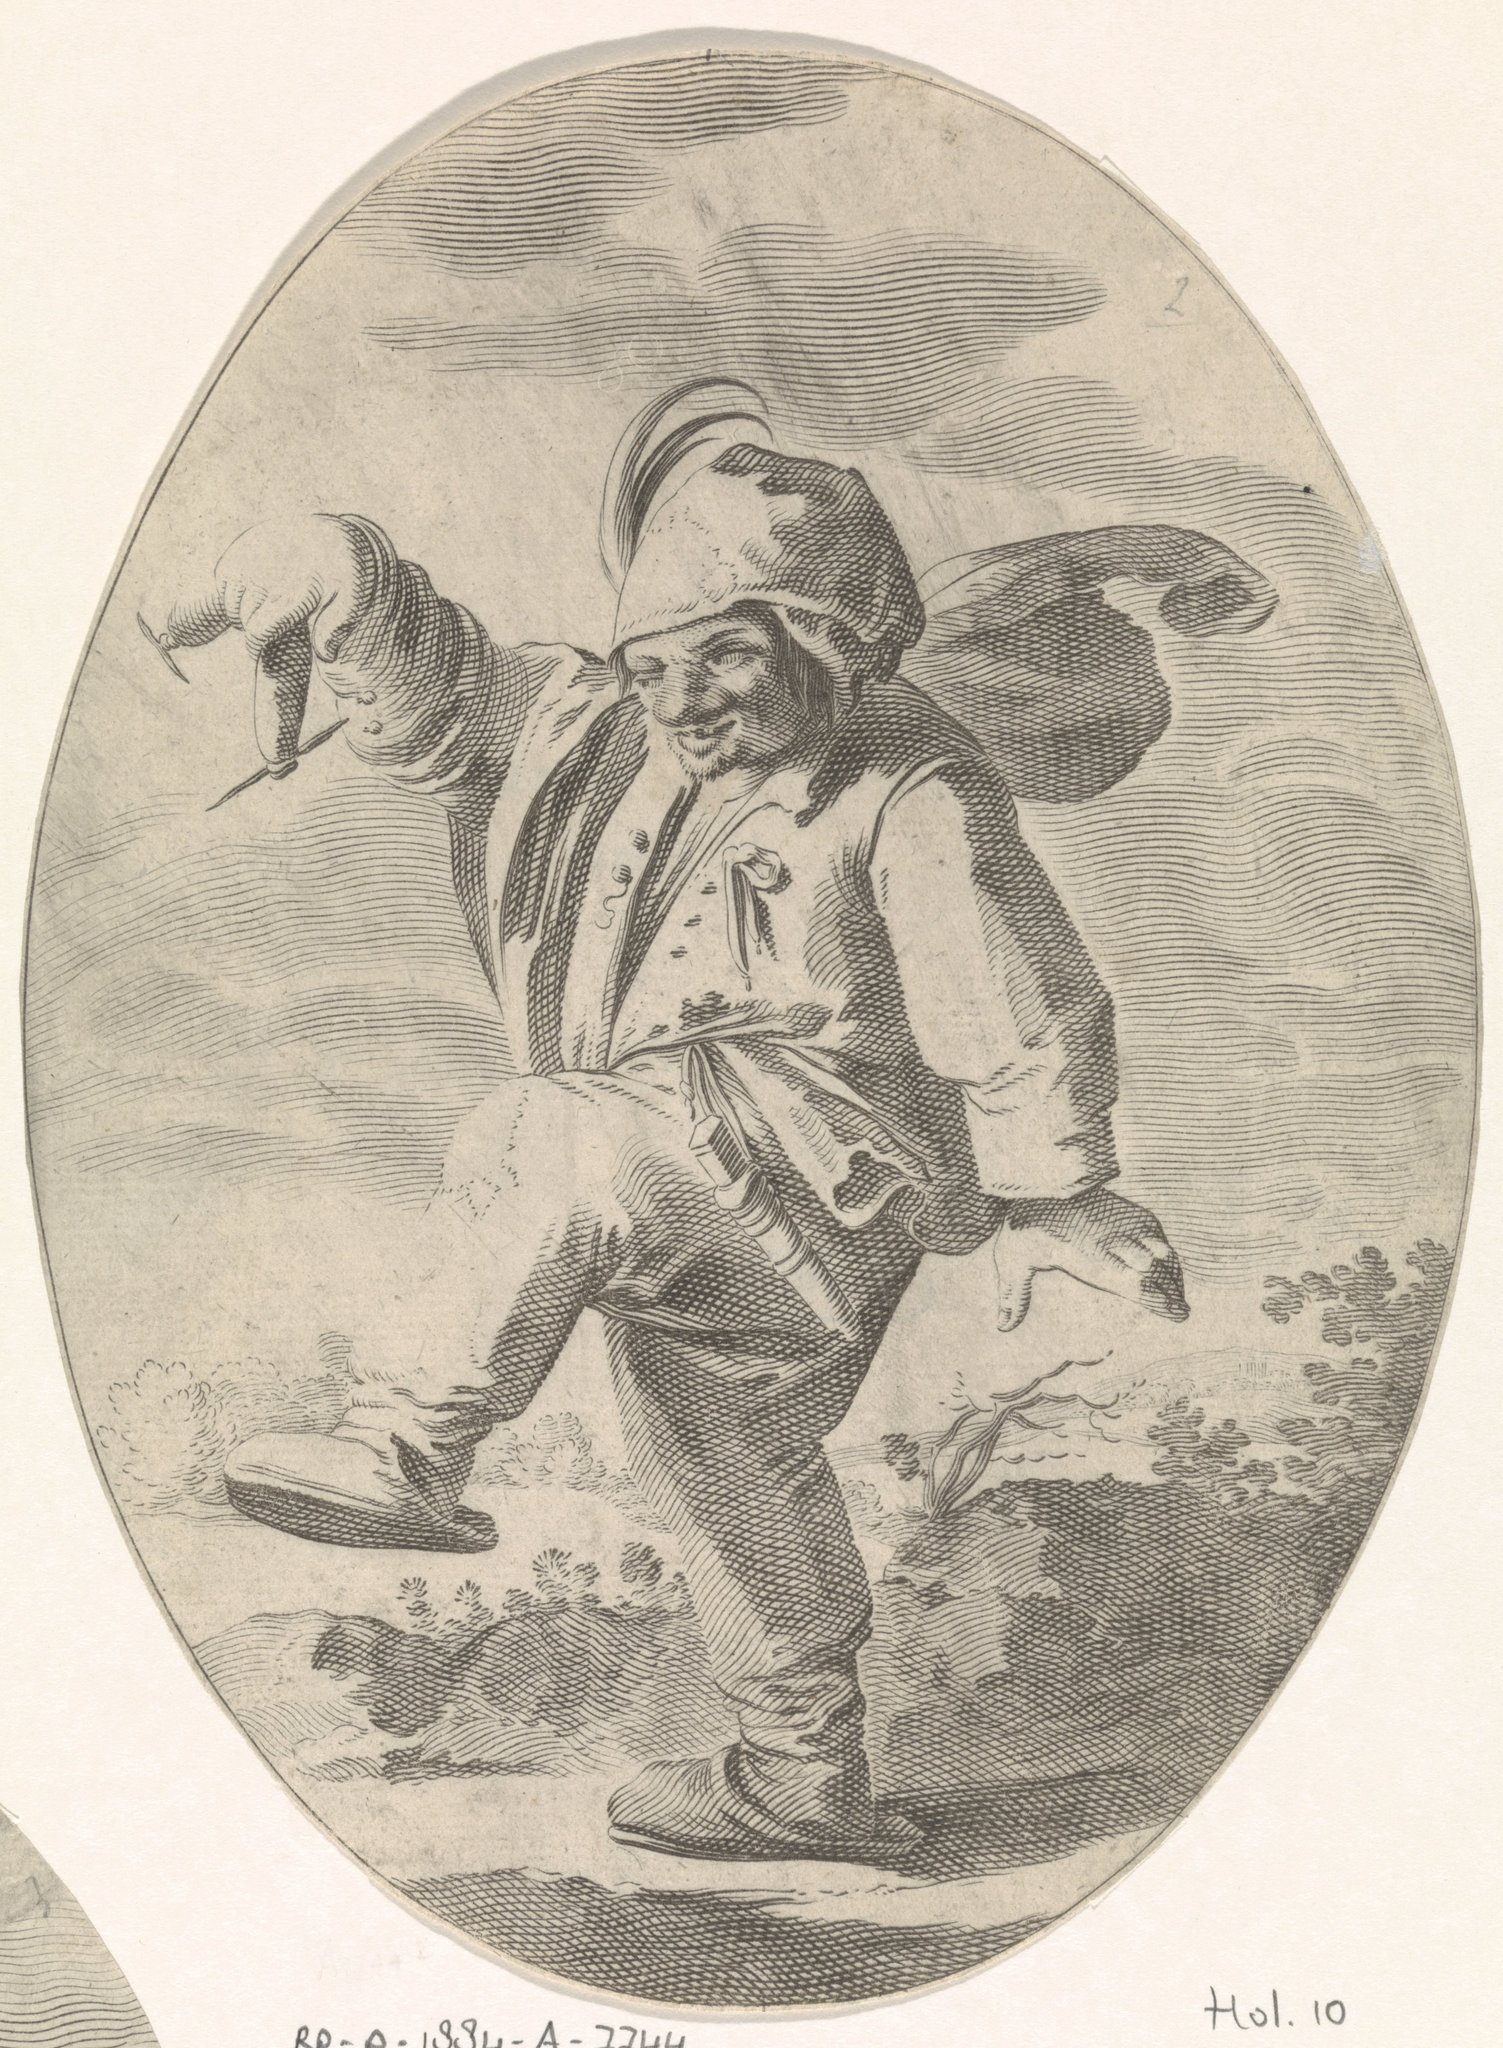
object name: print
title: Boeren en boerinnen in obscene houdingen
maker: nicolaes van lijnhoven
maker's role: draughtsman, print maker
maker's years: -1702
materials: paper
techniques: engraving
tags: scabrous scenes, pornography (+ variant), gesture-language, farmers, sausage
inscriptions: collector's mark: Lugt 2228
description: Een dansende boer in een landschap maakt een obsceen gebaar met een worst. De prent maakt deel uit van een zesdelige serie prenten met voorstellingen van boeren en boerinnen in obscene houdingen.